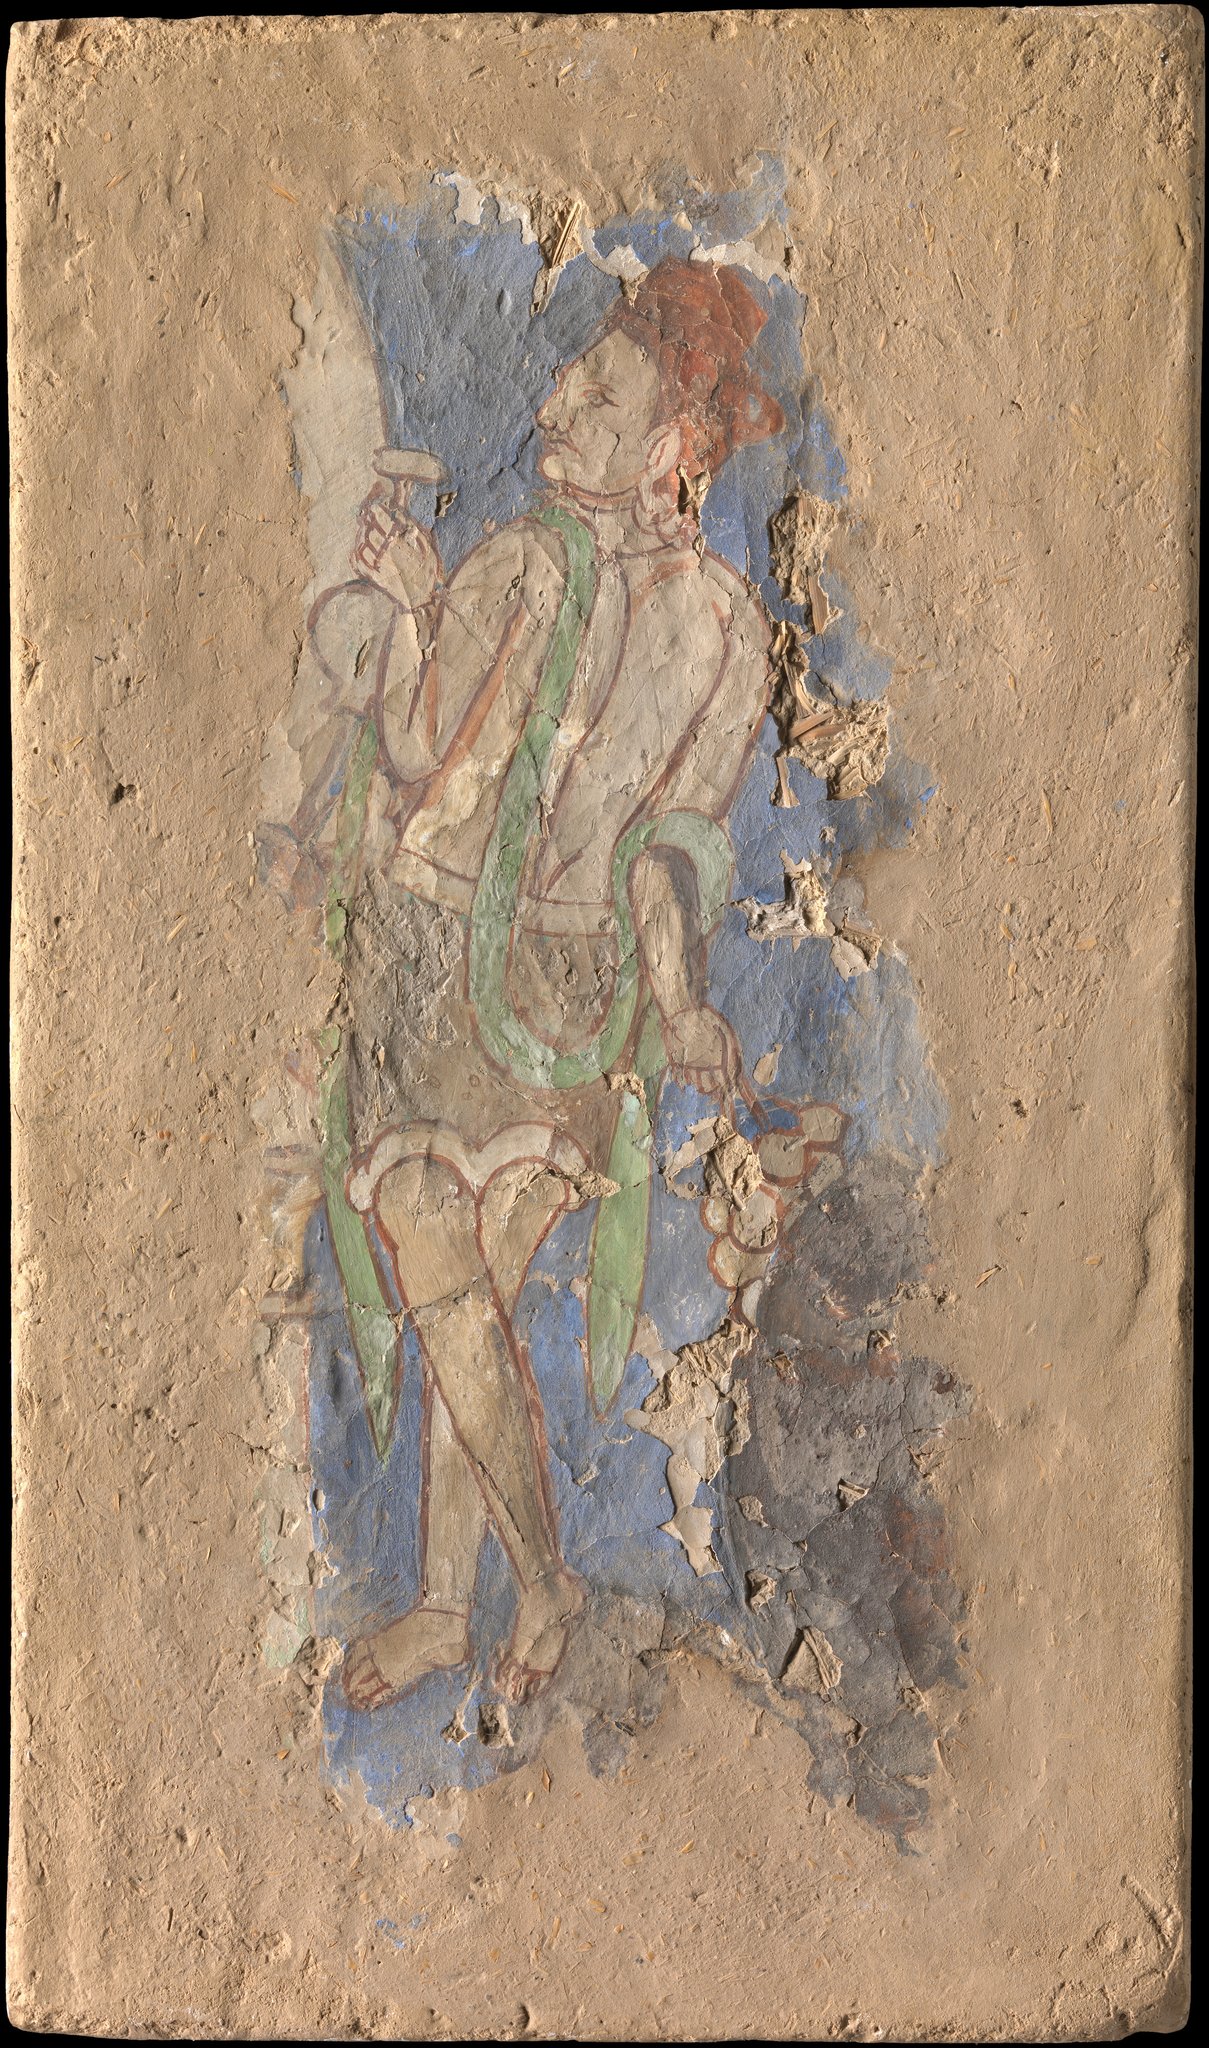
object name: wall painting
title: Attendant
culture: chinese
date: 501-700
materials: mud, pigment, plaster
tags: men